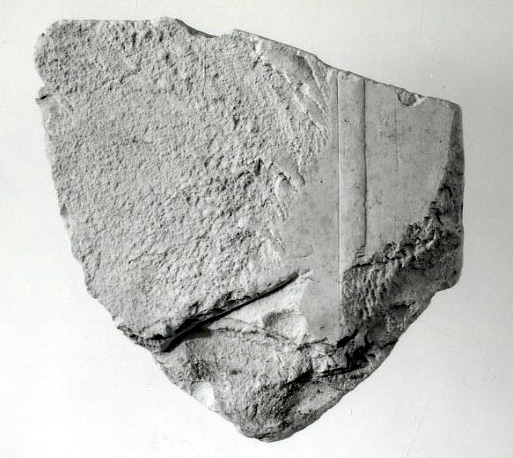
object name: relief fragment, tomb of meketre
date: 1981-1975 BCE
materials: limestone, paint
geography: egypt